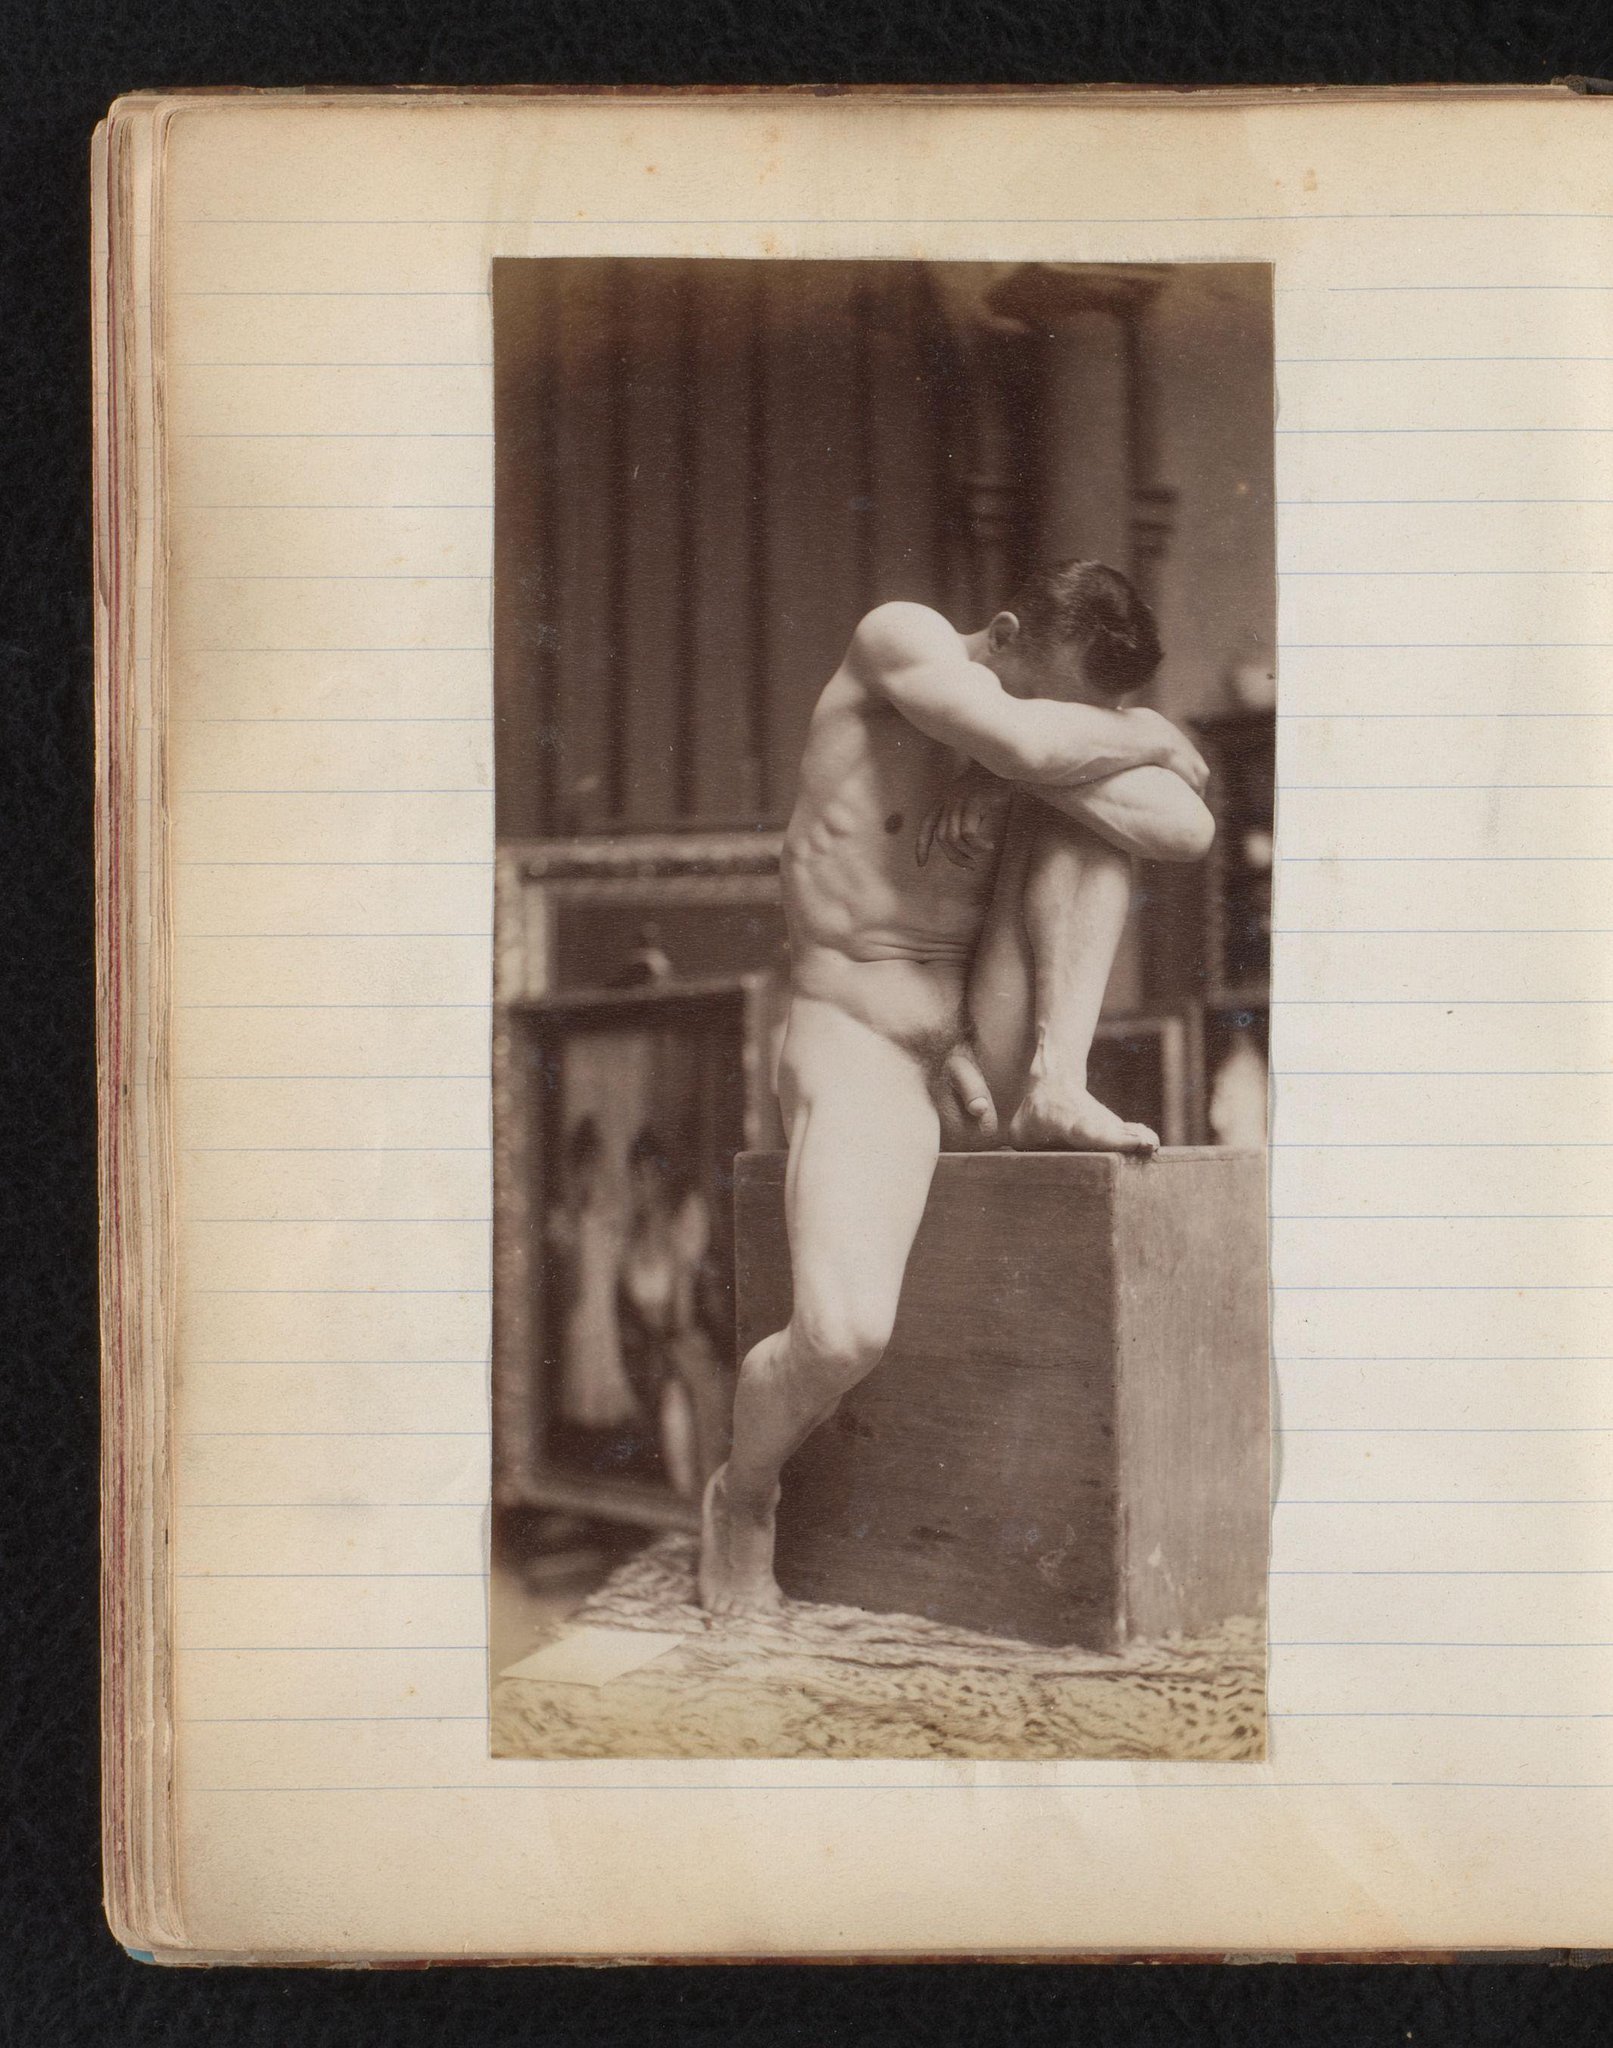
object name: photograph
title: Studie van een zittend mannelijk naaktmodel in het atelier van Jacques de Lalaing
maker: jacques lalaing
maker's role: painter, sculptor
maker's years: 1858-1917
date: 1883-1914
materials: photographic support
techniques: albumen print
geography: brussels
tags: the (nude) human figure; 'corpo humano' (ripa) (+ front view), adult man, the (nude) human figure; 'corpo humano' (ripa) (+ sitting), artist (in general) working from nude model